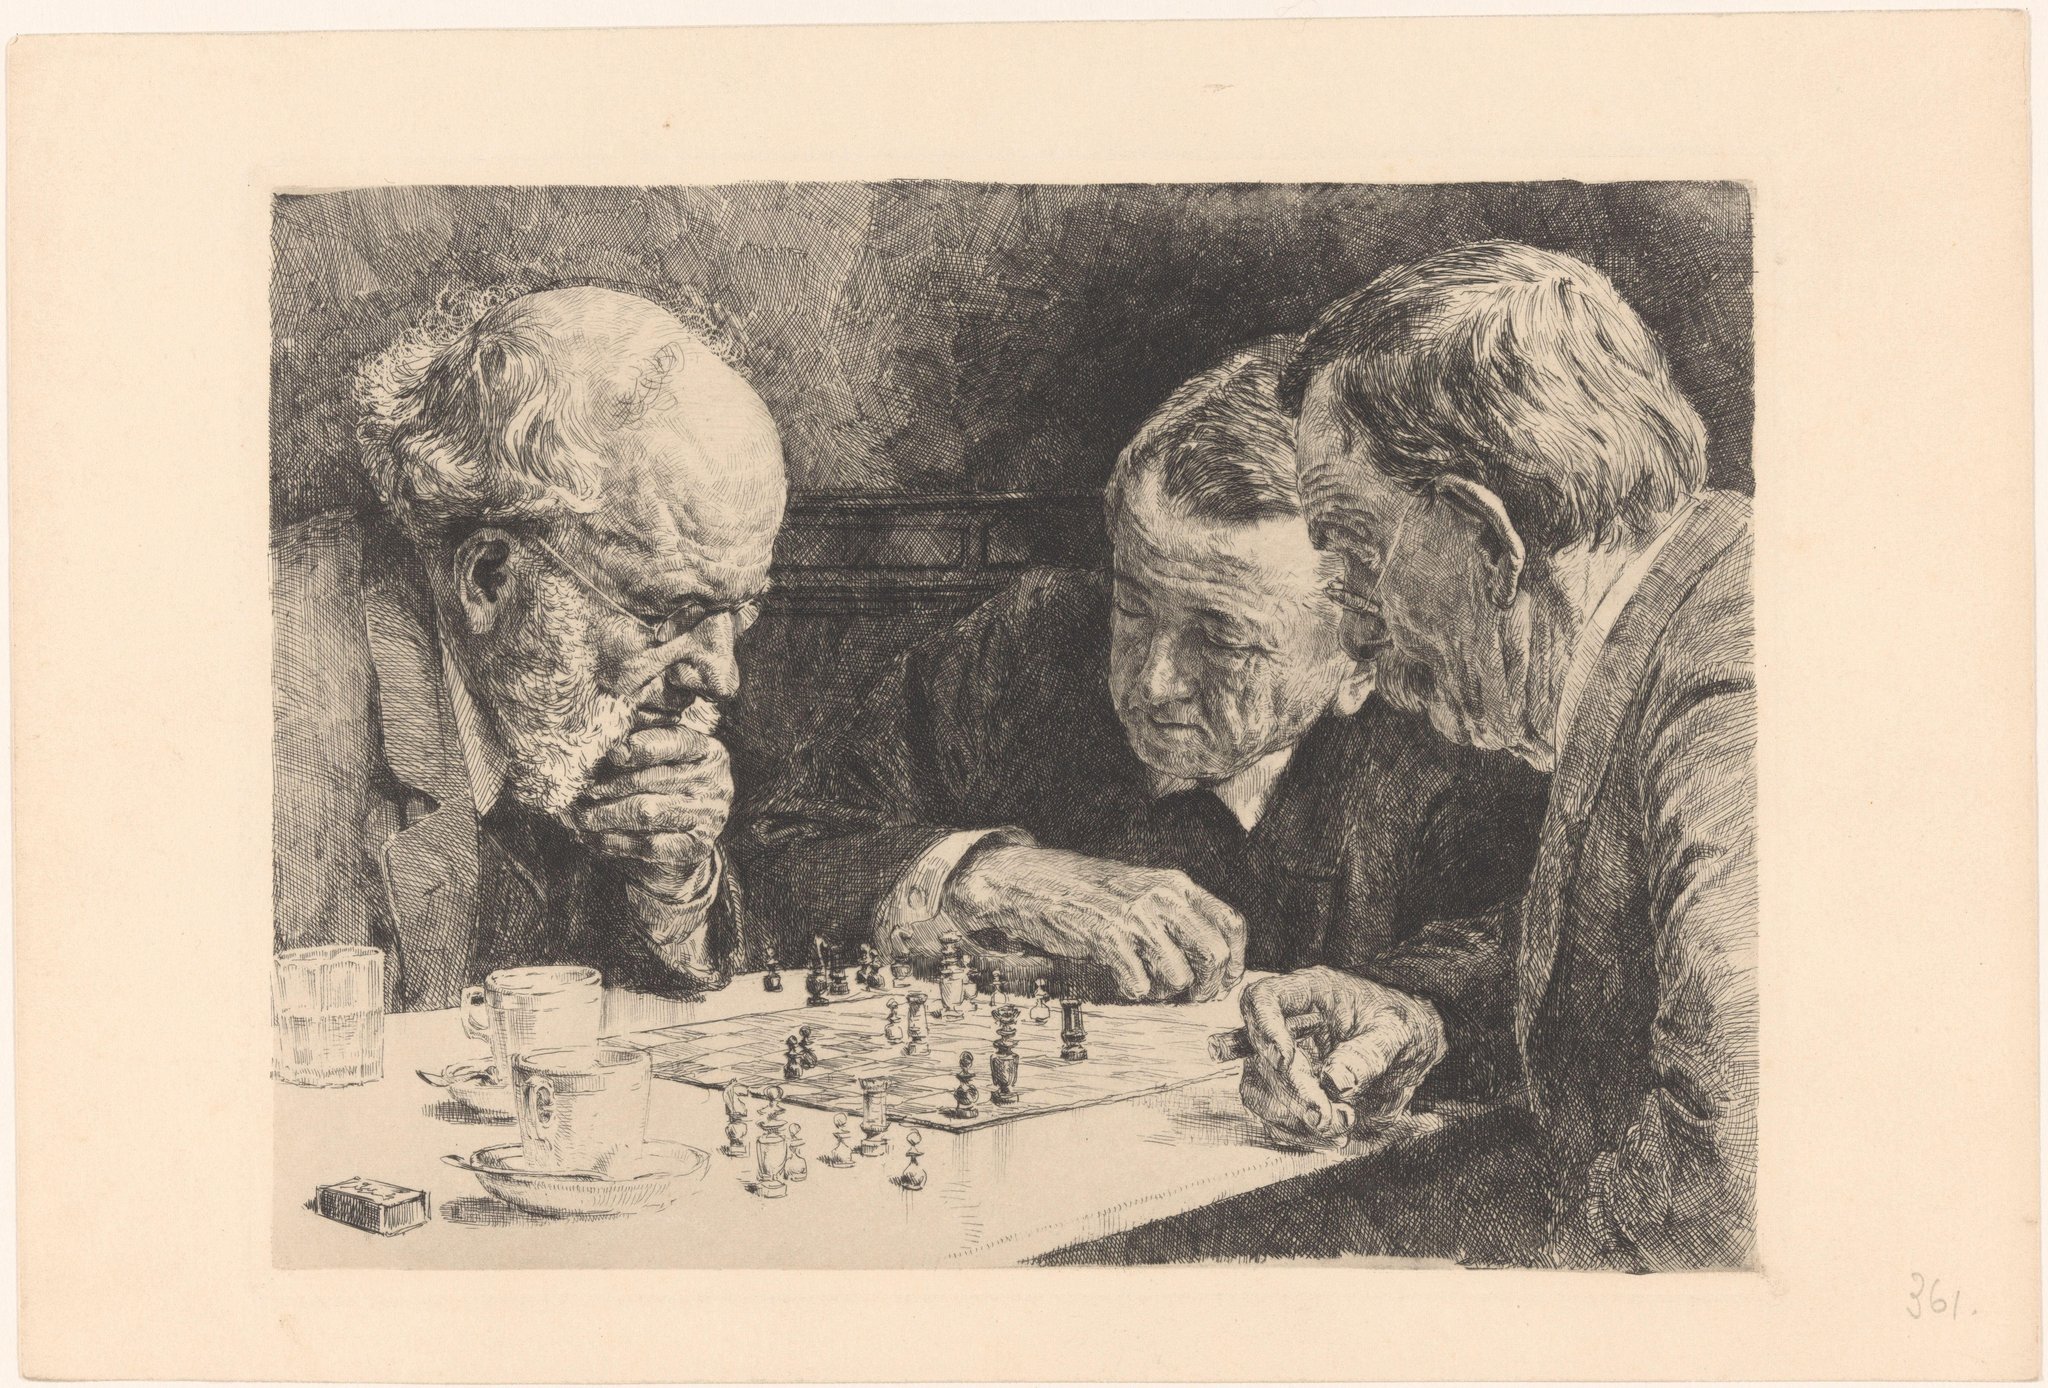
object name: print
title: Drie mannen bij schaakspel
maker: paul hey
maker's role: painter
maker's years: 1867-1952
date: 1877-1952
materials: paper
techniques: etching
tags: chess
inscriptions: collector's mark: Lugt 2228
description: De linker man heeft zijn hand bij zijn kin. De rechter man heeft een sigaar in zijn hand. Links op tafel staan twee koffiekoppen, een glas en een luciferdoos.